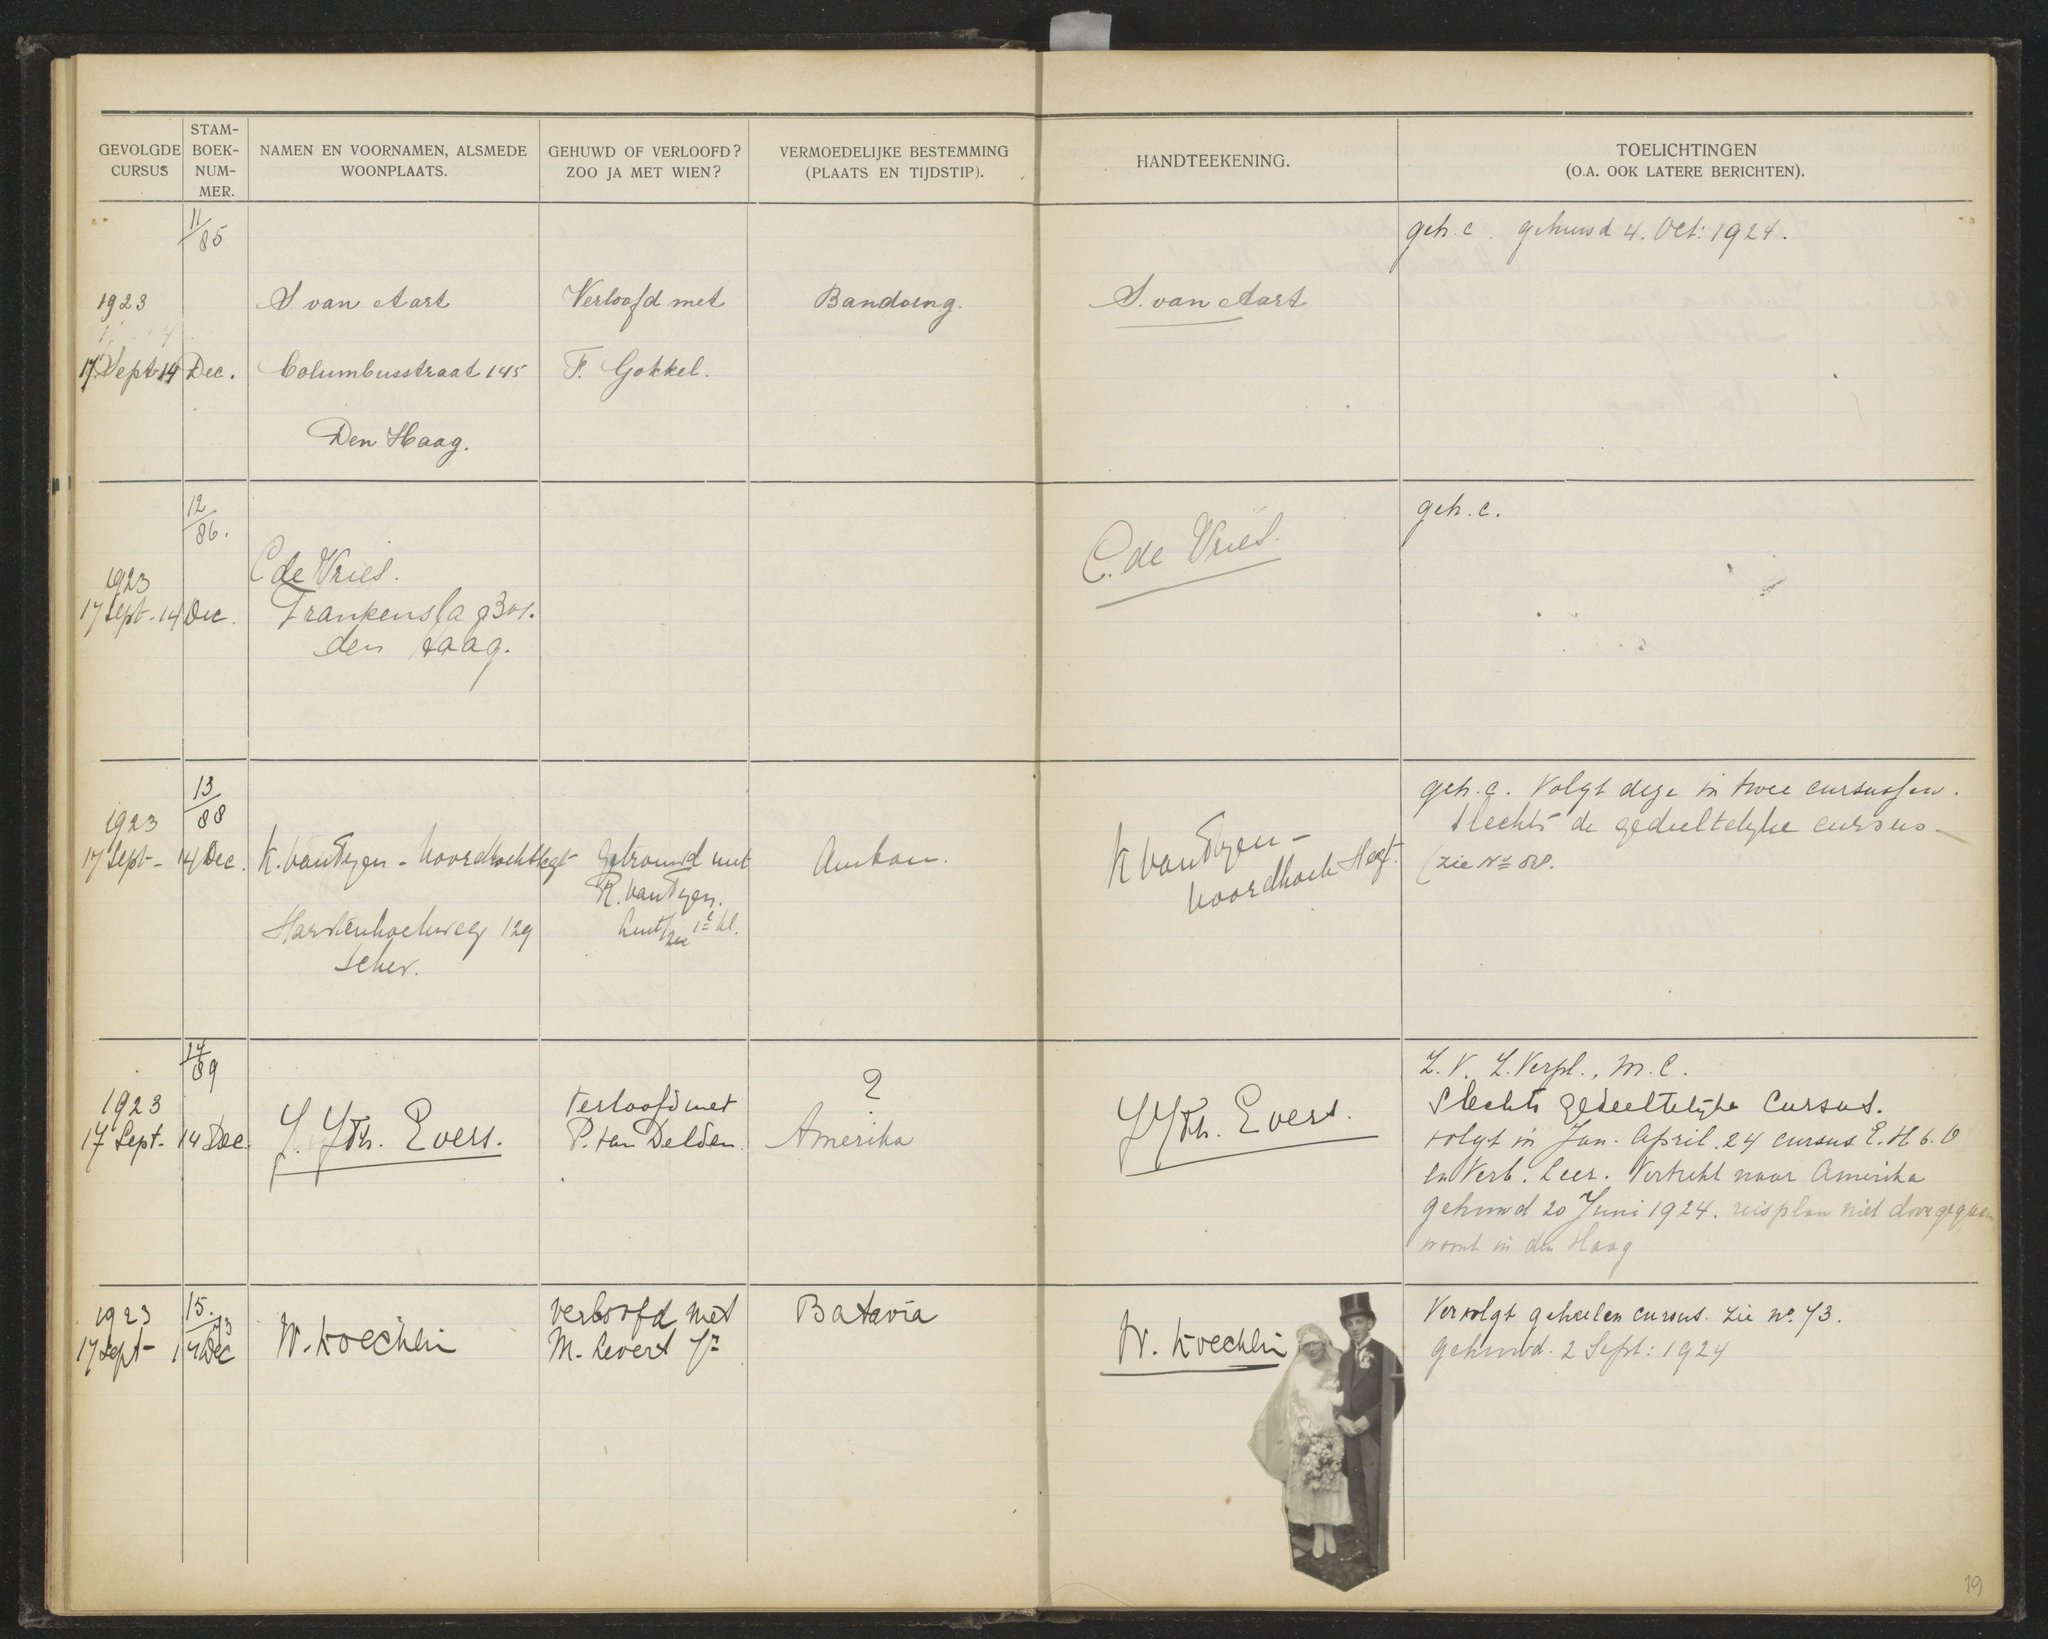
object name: album leaf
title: Blad 19 uit Stamboek van de leerlingen der Koloniale School voor Meisjes en Vrouwen te 's-Gravenhage deel I (1921-1929)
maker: Anonymous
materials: paper, photographic support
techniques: photography, printing, writing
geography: the hague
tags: further education (+ pupil), further education, the hague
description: Twee pagina's met gegevens van de deelnemers aan de 7e driemaandelijkse cursus van 17 september tot en met 14 december 1923, stamboeknummers 85 tot en met 89 (en 73 nogmaals). Onderdeel van Stamboek van de leerlingen der Koloniale School voor Meisjes en Vrouwen te 's-Gravenhage deel I (1921-1929).